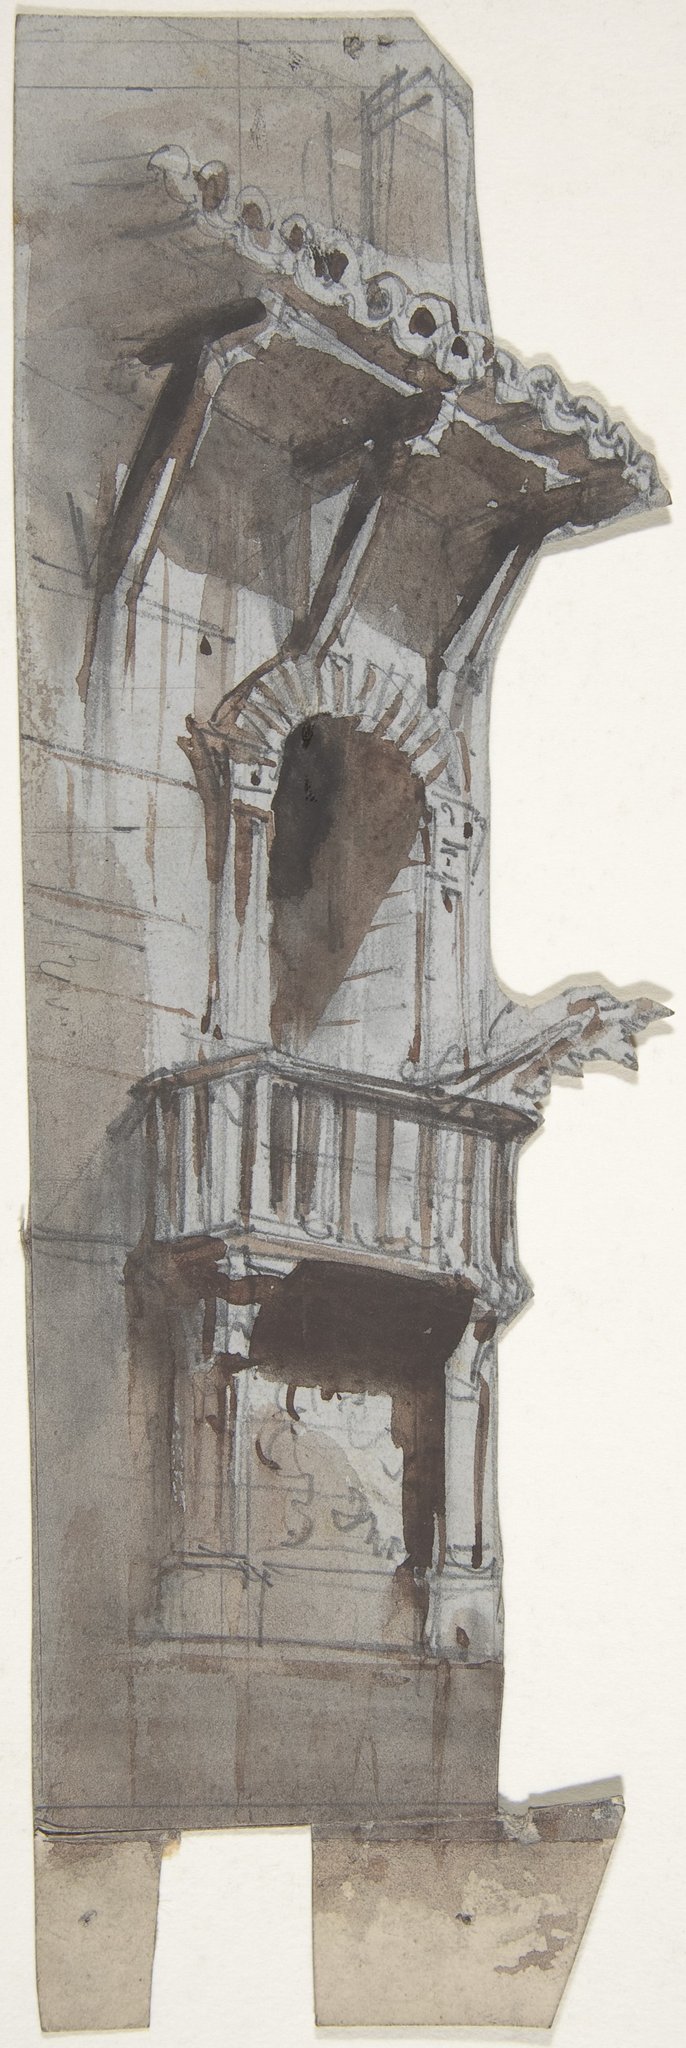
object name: drawing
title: Design for a Stage Set at the Opéra, Paris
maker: eugène cicéri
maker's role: artist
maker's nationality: french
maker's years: 1813-1890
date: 1830-1890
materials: graphite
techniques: brush, wash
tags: balconies,buildings,stage design